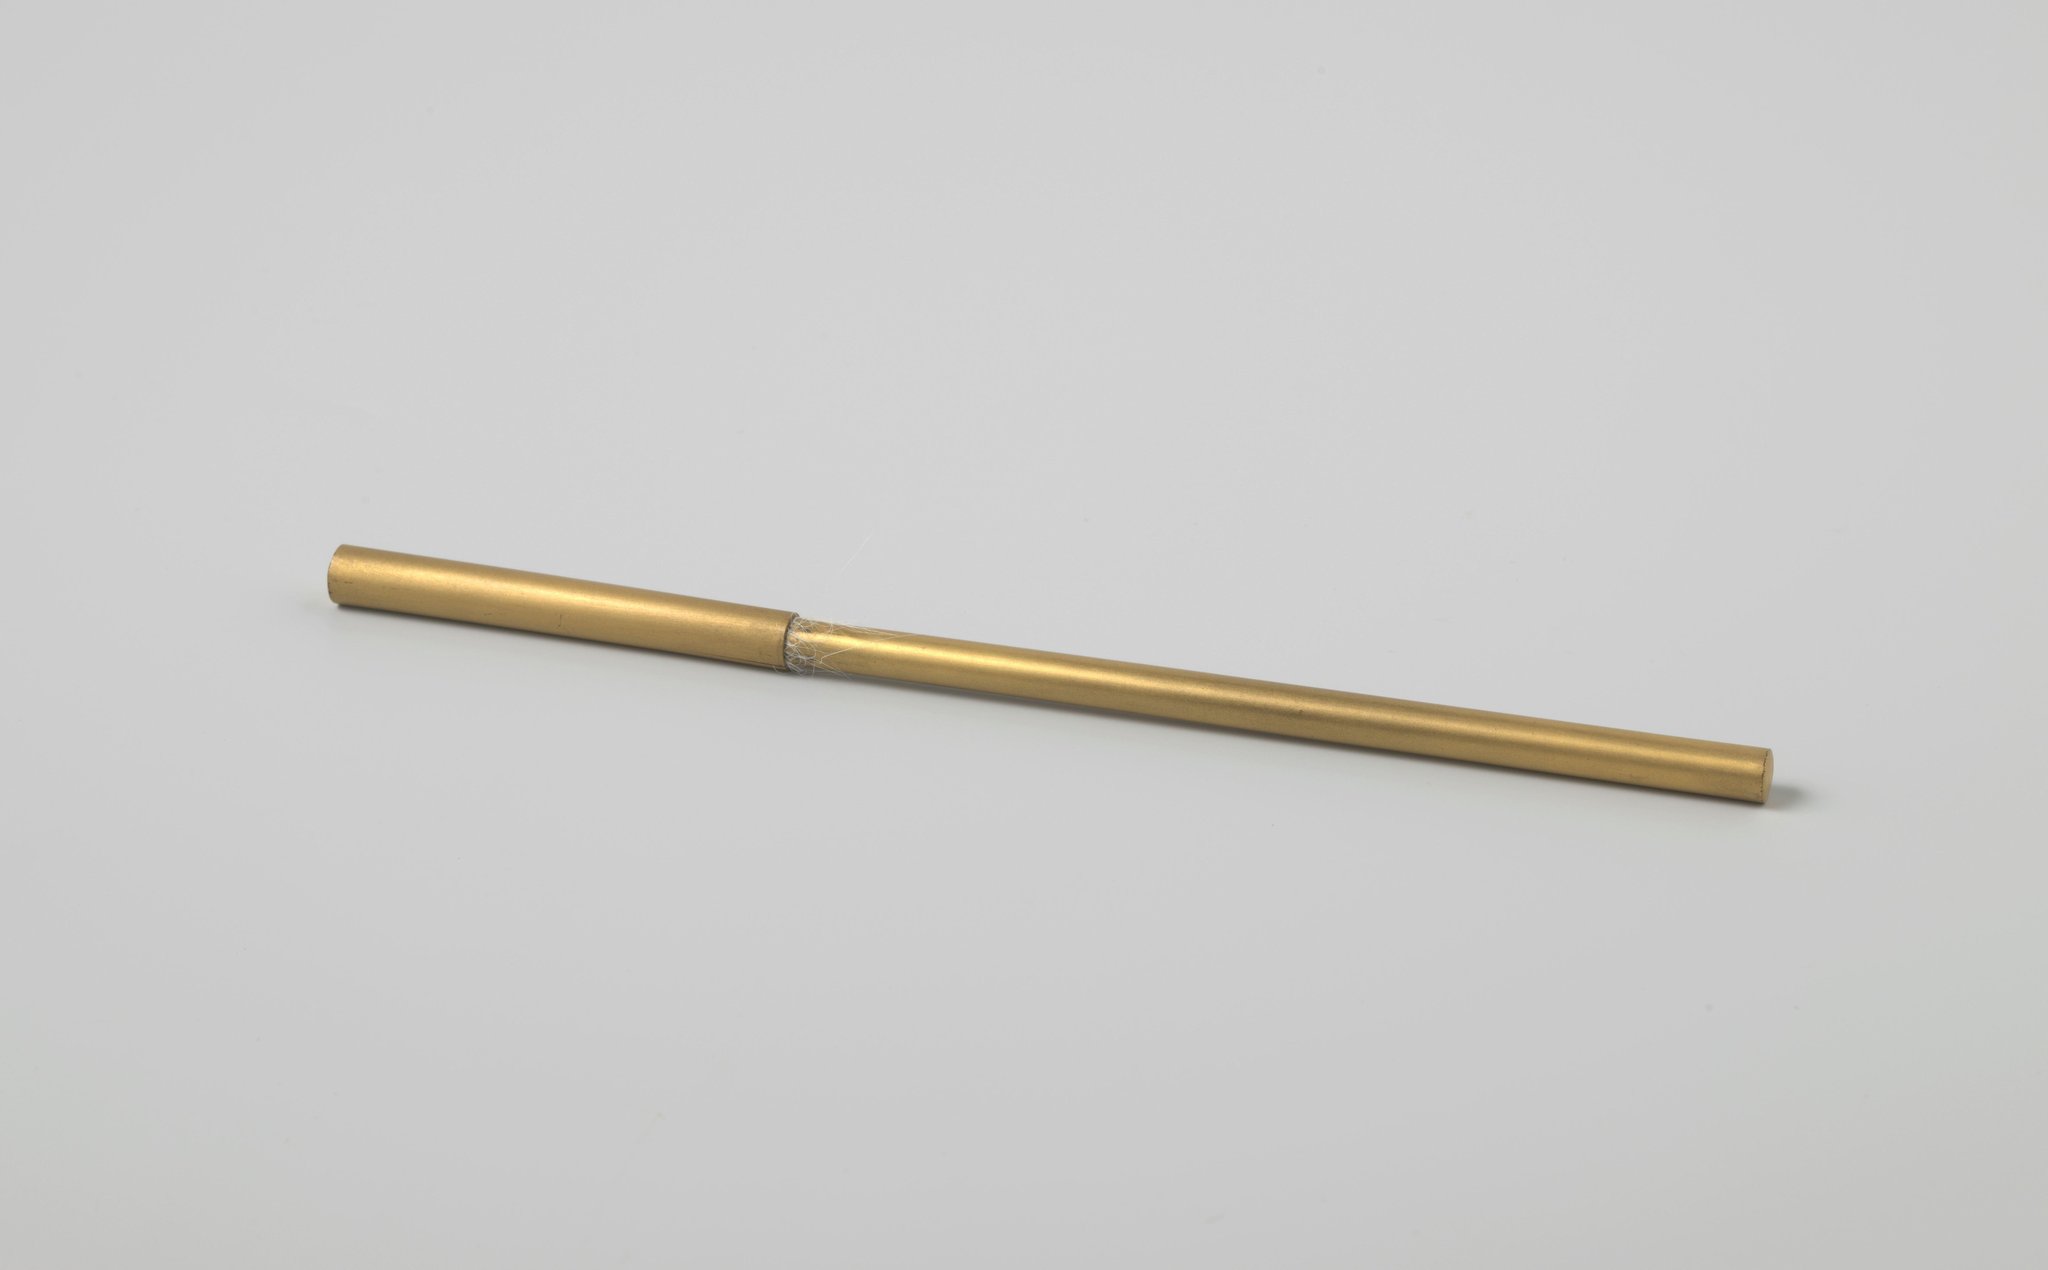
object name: suzuribako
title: Penseel behorende bij suzuribako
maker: Anonymous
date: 1850-1900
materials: lacquer, wood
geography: japan